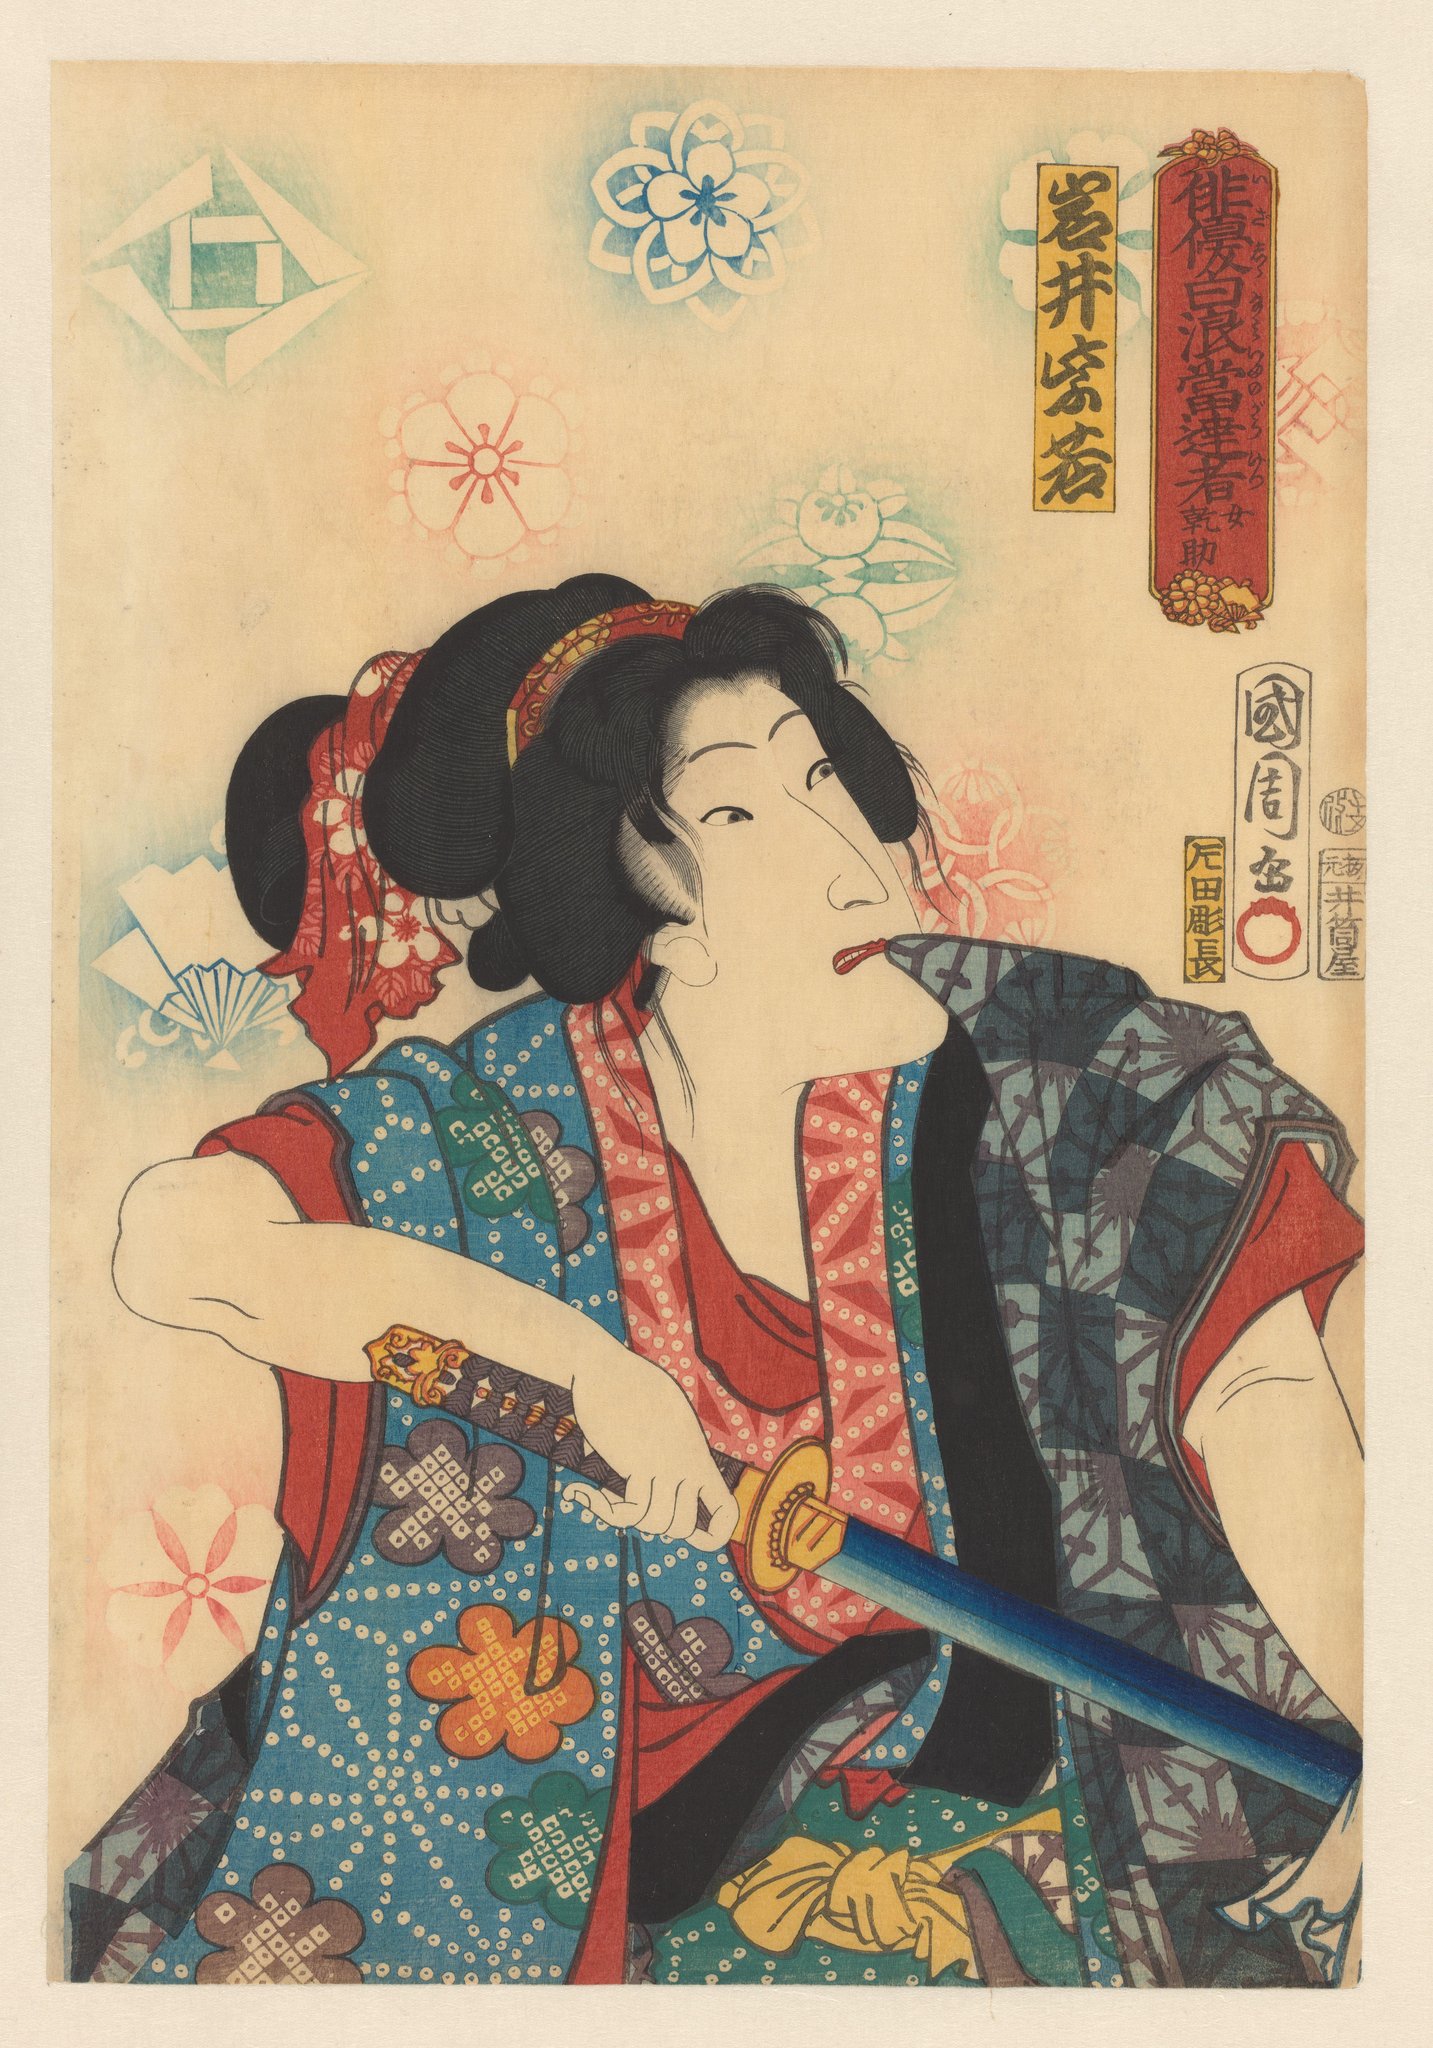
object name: print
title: Onna Kansuke draws sword while pulling kimono sleeve with teeth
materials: paper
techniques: woodcut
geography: japan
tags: hacking and thrusting weapons: sword, portrait of actor, actress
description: Bandiet Onna Kansuke trekt zijn zwaard, terwijl hij met zijn tanden de mouw van zijn kimono optrekt. Onna Kansuke (Onna betekent 'vrouw') was berucht vanwege zijn vrouwelijke uiterlijk, waarmee hij veel vijanden op het verkeerde been kon zetten. Onna Kansuke wordt hier gespeeld door kabuki acteur Iwai Shijaku II.